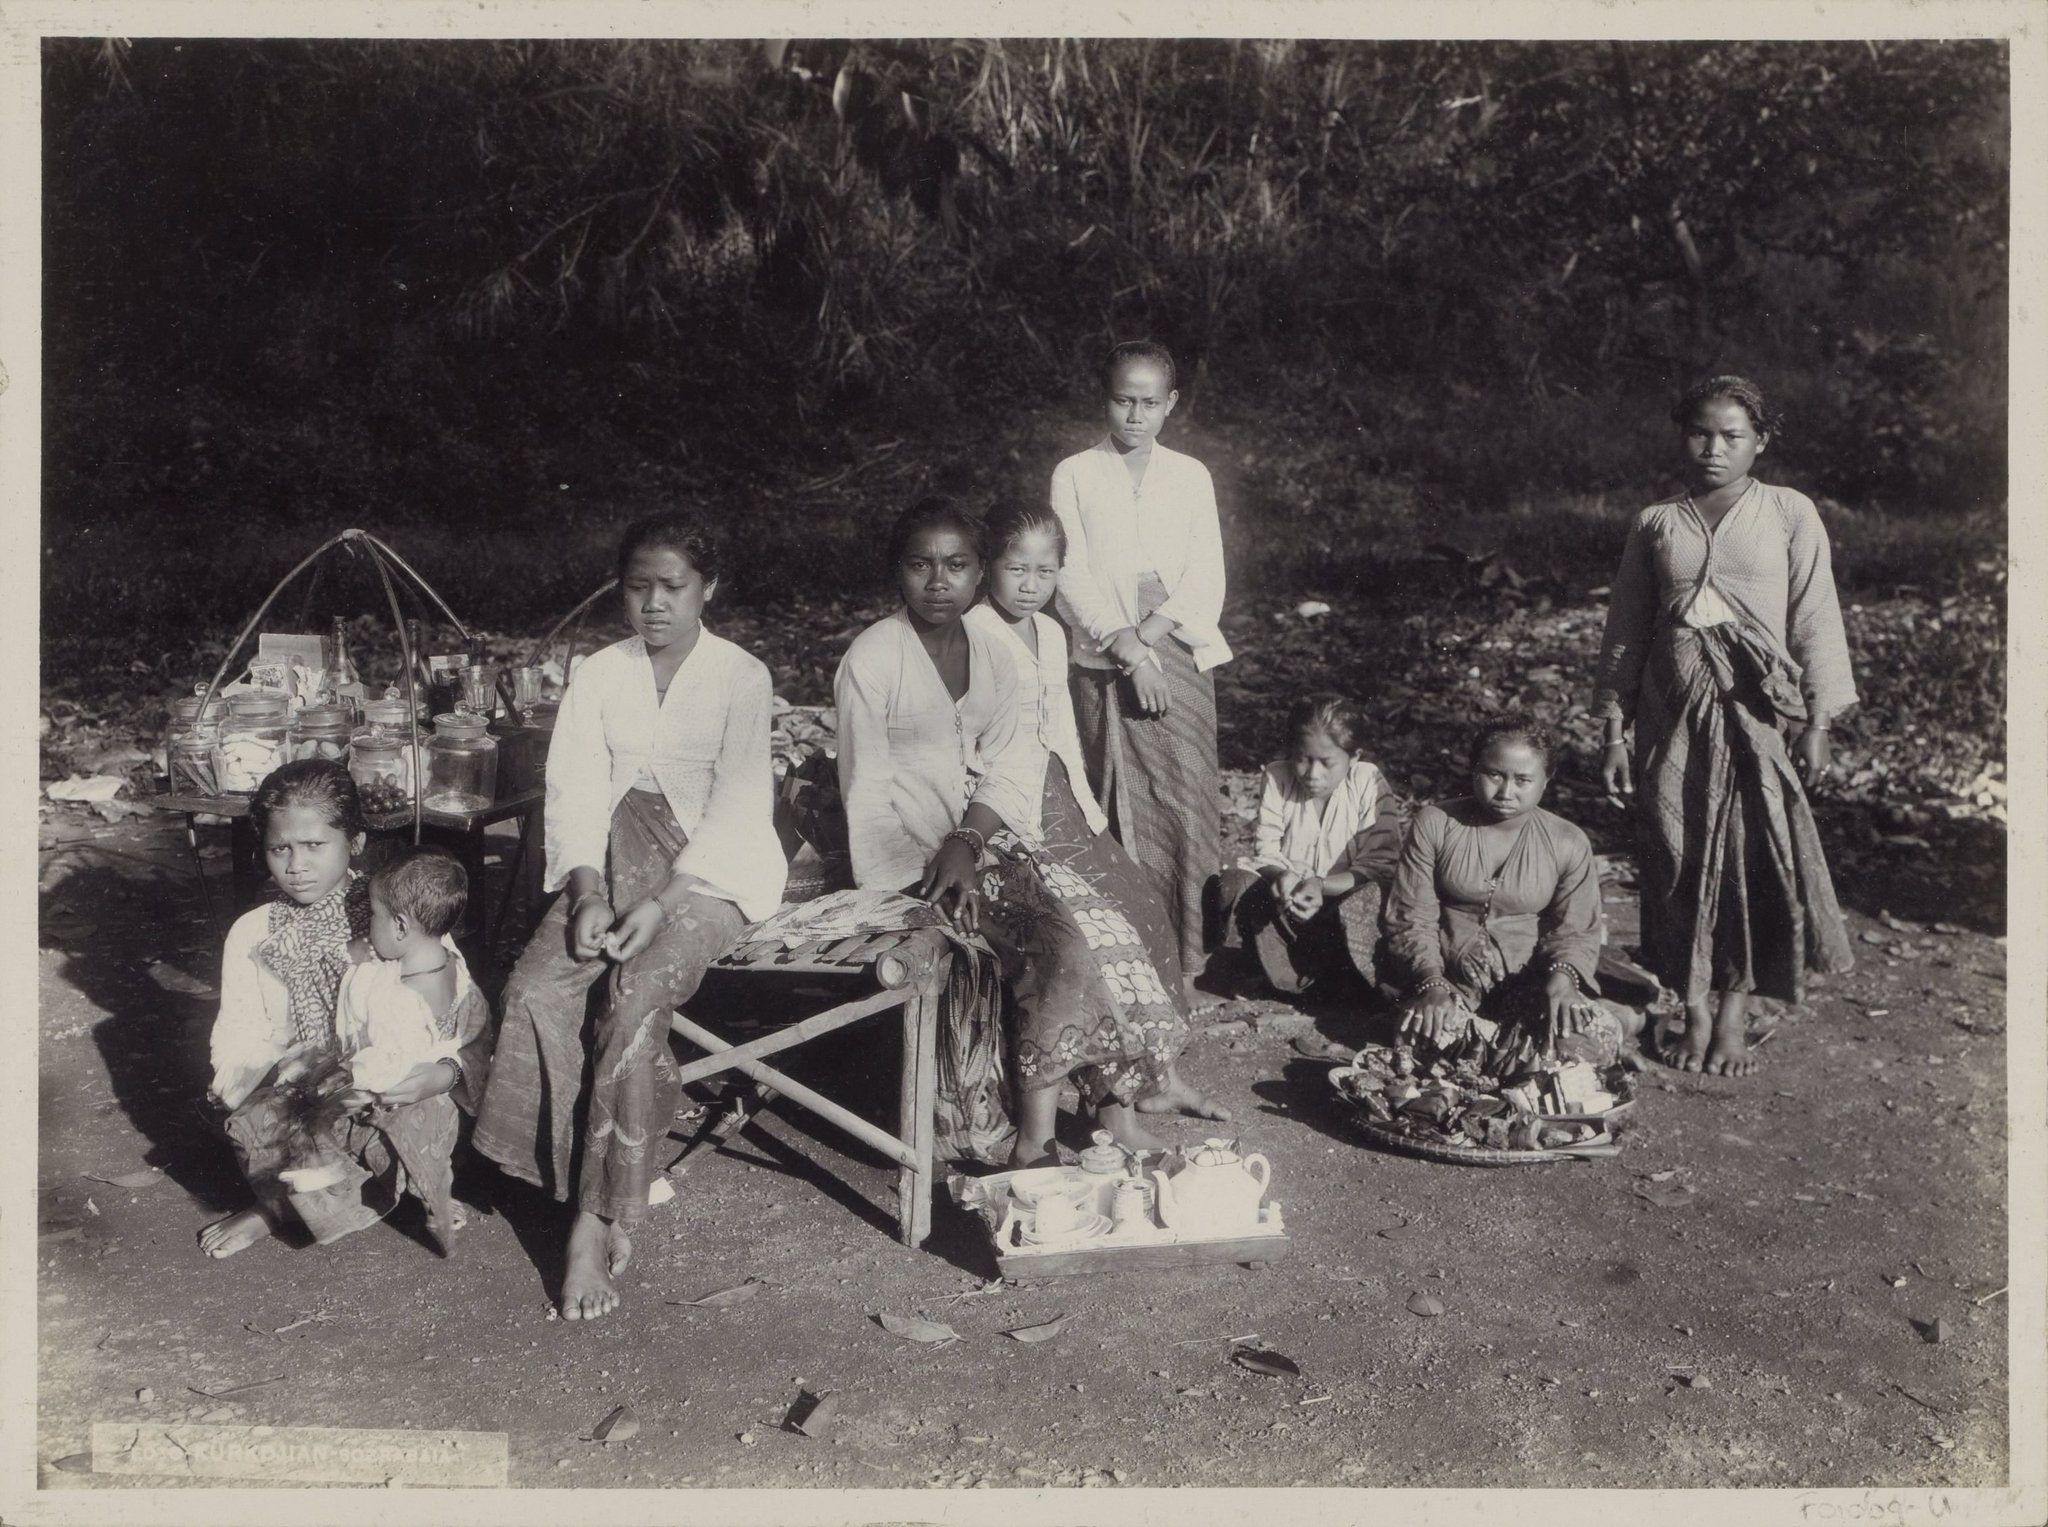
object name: photograph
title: Indische vrouwen en kinderen met uitgestalde waren langs de kant van de weg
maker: onnes kurkdjian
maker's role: fotograaf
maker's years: 1851-1903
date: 1912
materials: paper, photographic support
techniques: gelatin silver print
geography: dutch east indies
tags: selling, merchant, salesman, dutch east indies, the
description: Onderdeel van Reisalbum met veertig foto's van Nederlands-Indië.